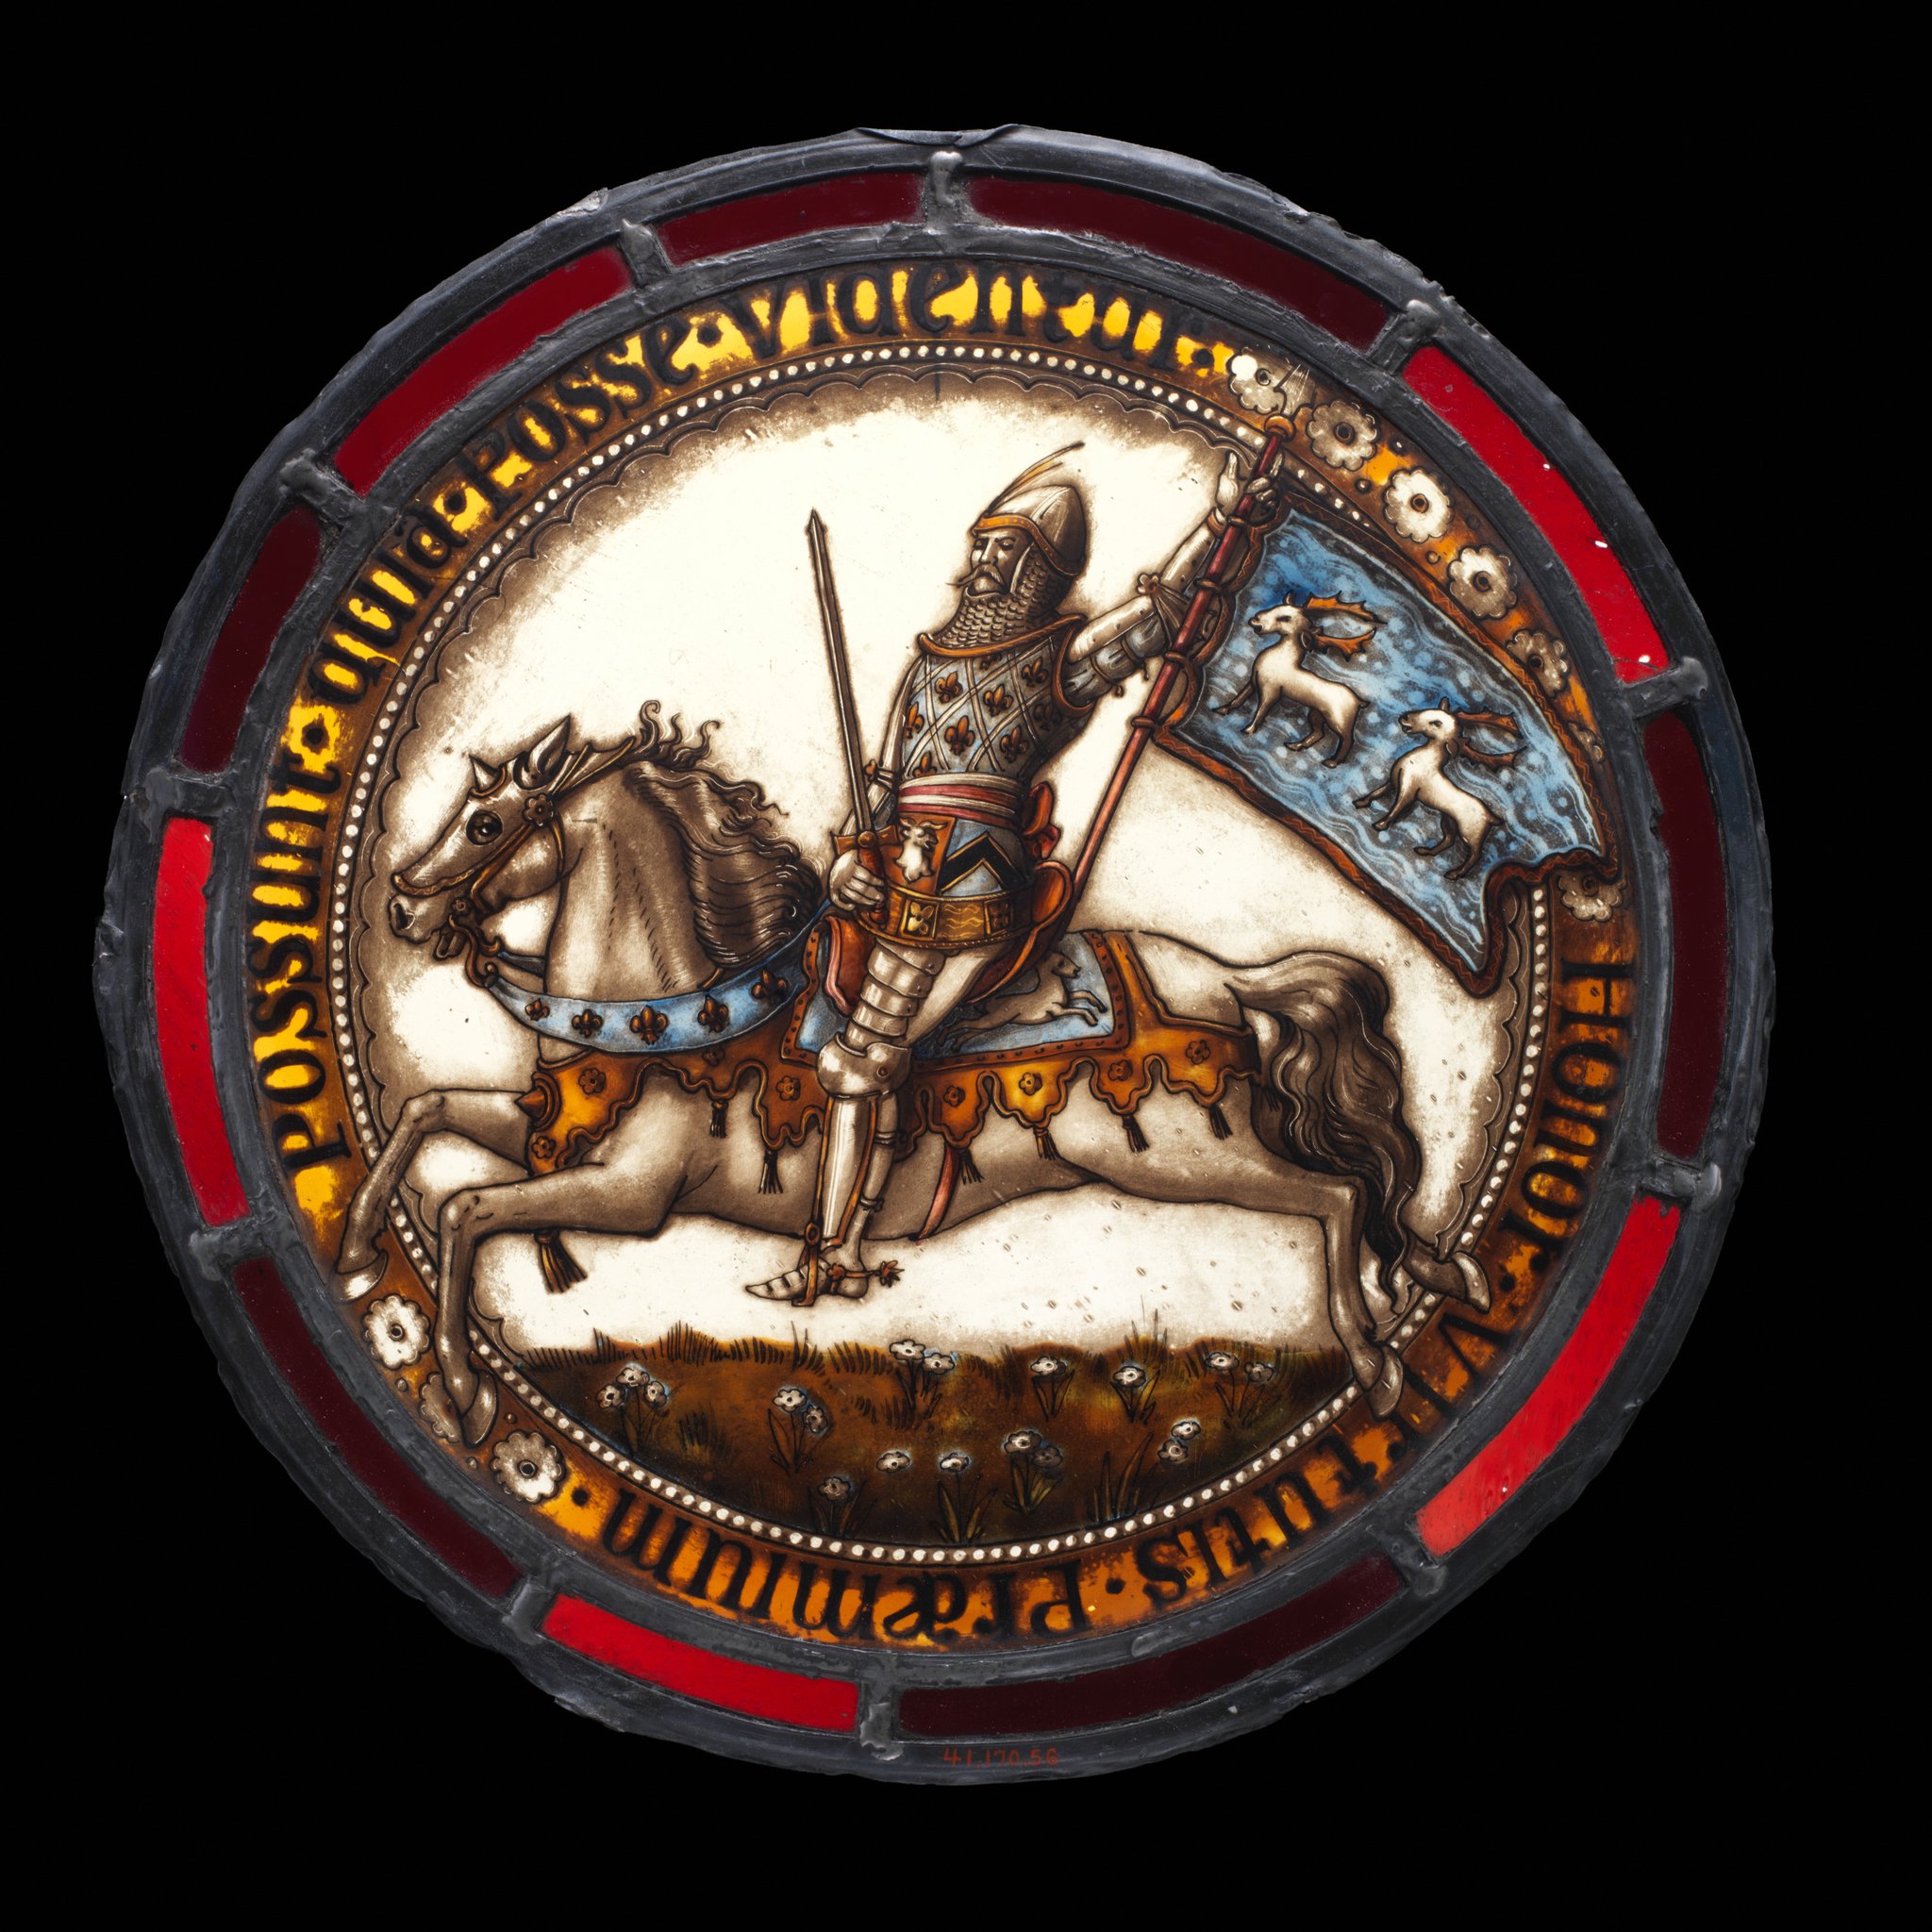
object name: medallion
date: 1801-1850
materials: glass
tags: armor,swords,horses,flags,knights